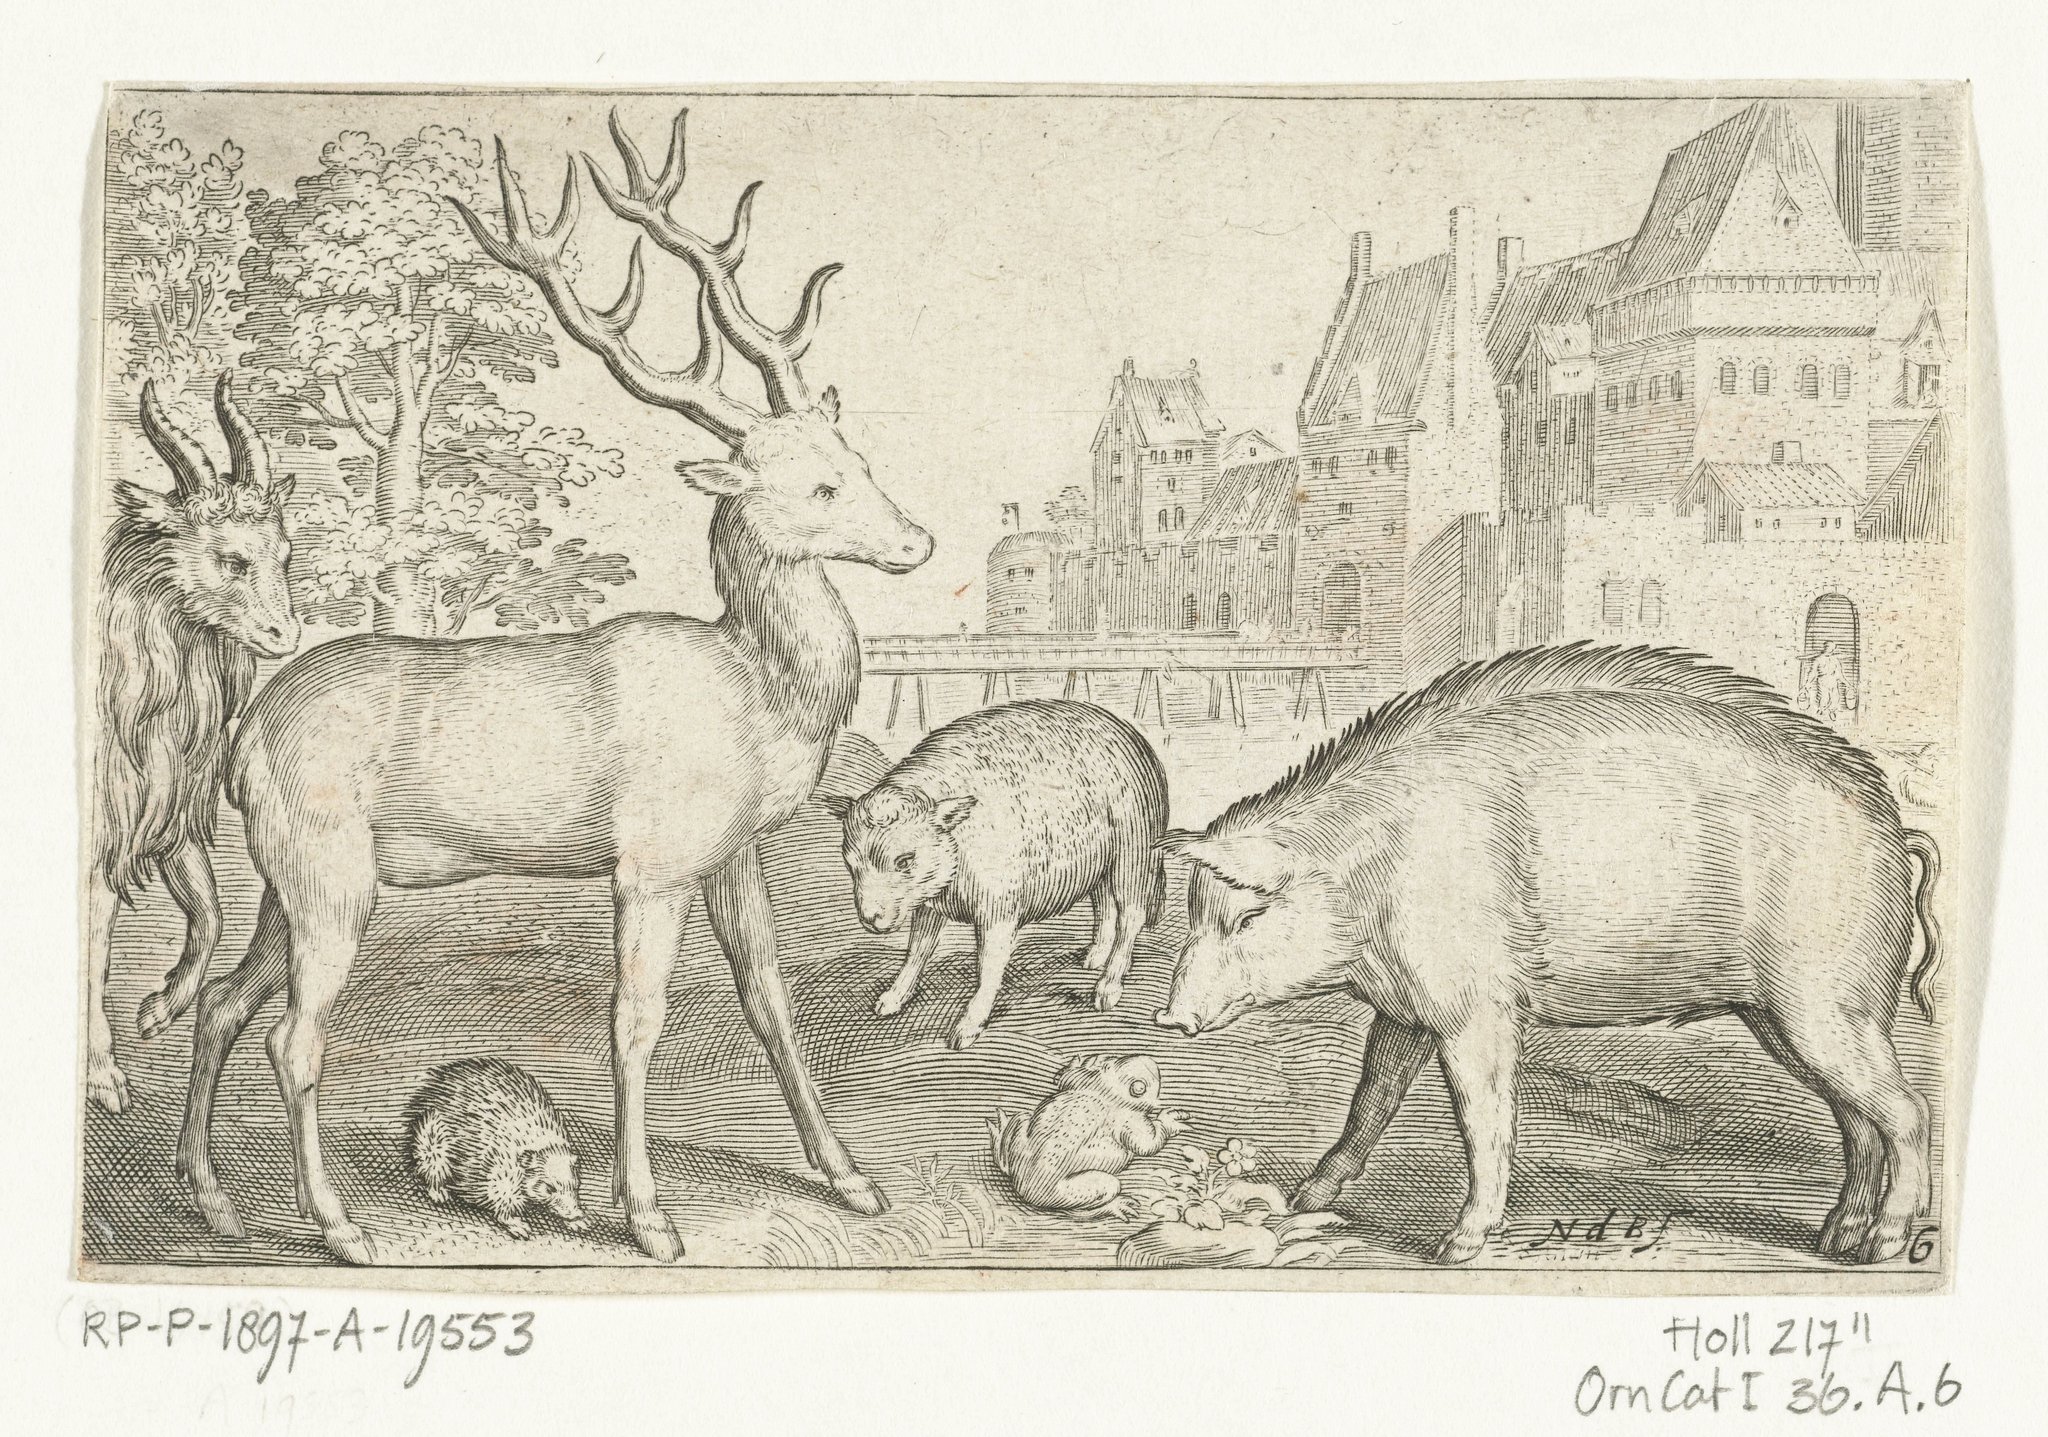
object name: print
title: Hert, egel, schaap, kikker en varken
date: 1594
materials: paper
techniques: engraving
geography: netherlands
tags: pig, hoofed animals, other mammals: hedgehog, groups of animals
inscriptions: collector's mark: Lugt 2228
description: Prent uit serie Animalivm qvadrvpedvm van twaalf prenten met dieren (viervoeters) in landschappen. Hollstein beschrijft twee staten, als eerste staat een uitgave van Assuerus van Londerseel voor de nummering (gedateerd 1594) en als tweede staat een uitgave van Claes Jansz. Visscher (II) met nummering (gedateerd 1621). Er is echter nog een andere editie bekend van uitgever Christoffel van Sichem welke tussen deze twee staten in geplaatst kan worden. Verschillende drukken van Visscher vertonen nog sporen van een adres van Van Sichem, op een enkel blad in de collectie van het RMA staat zijn adres, vergelijk RP-P-OB-16.158. De editie van Visscher is gedrukt van zeer versleten platen, zie De Groot 1988, p. 36, 37.